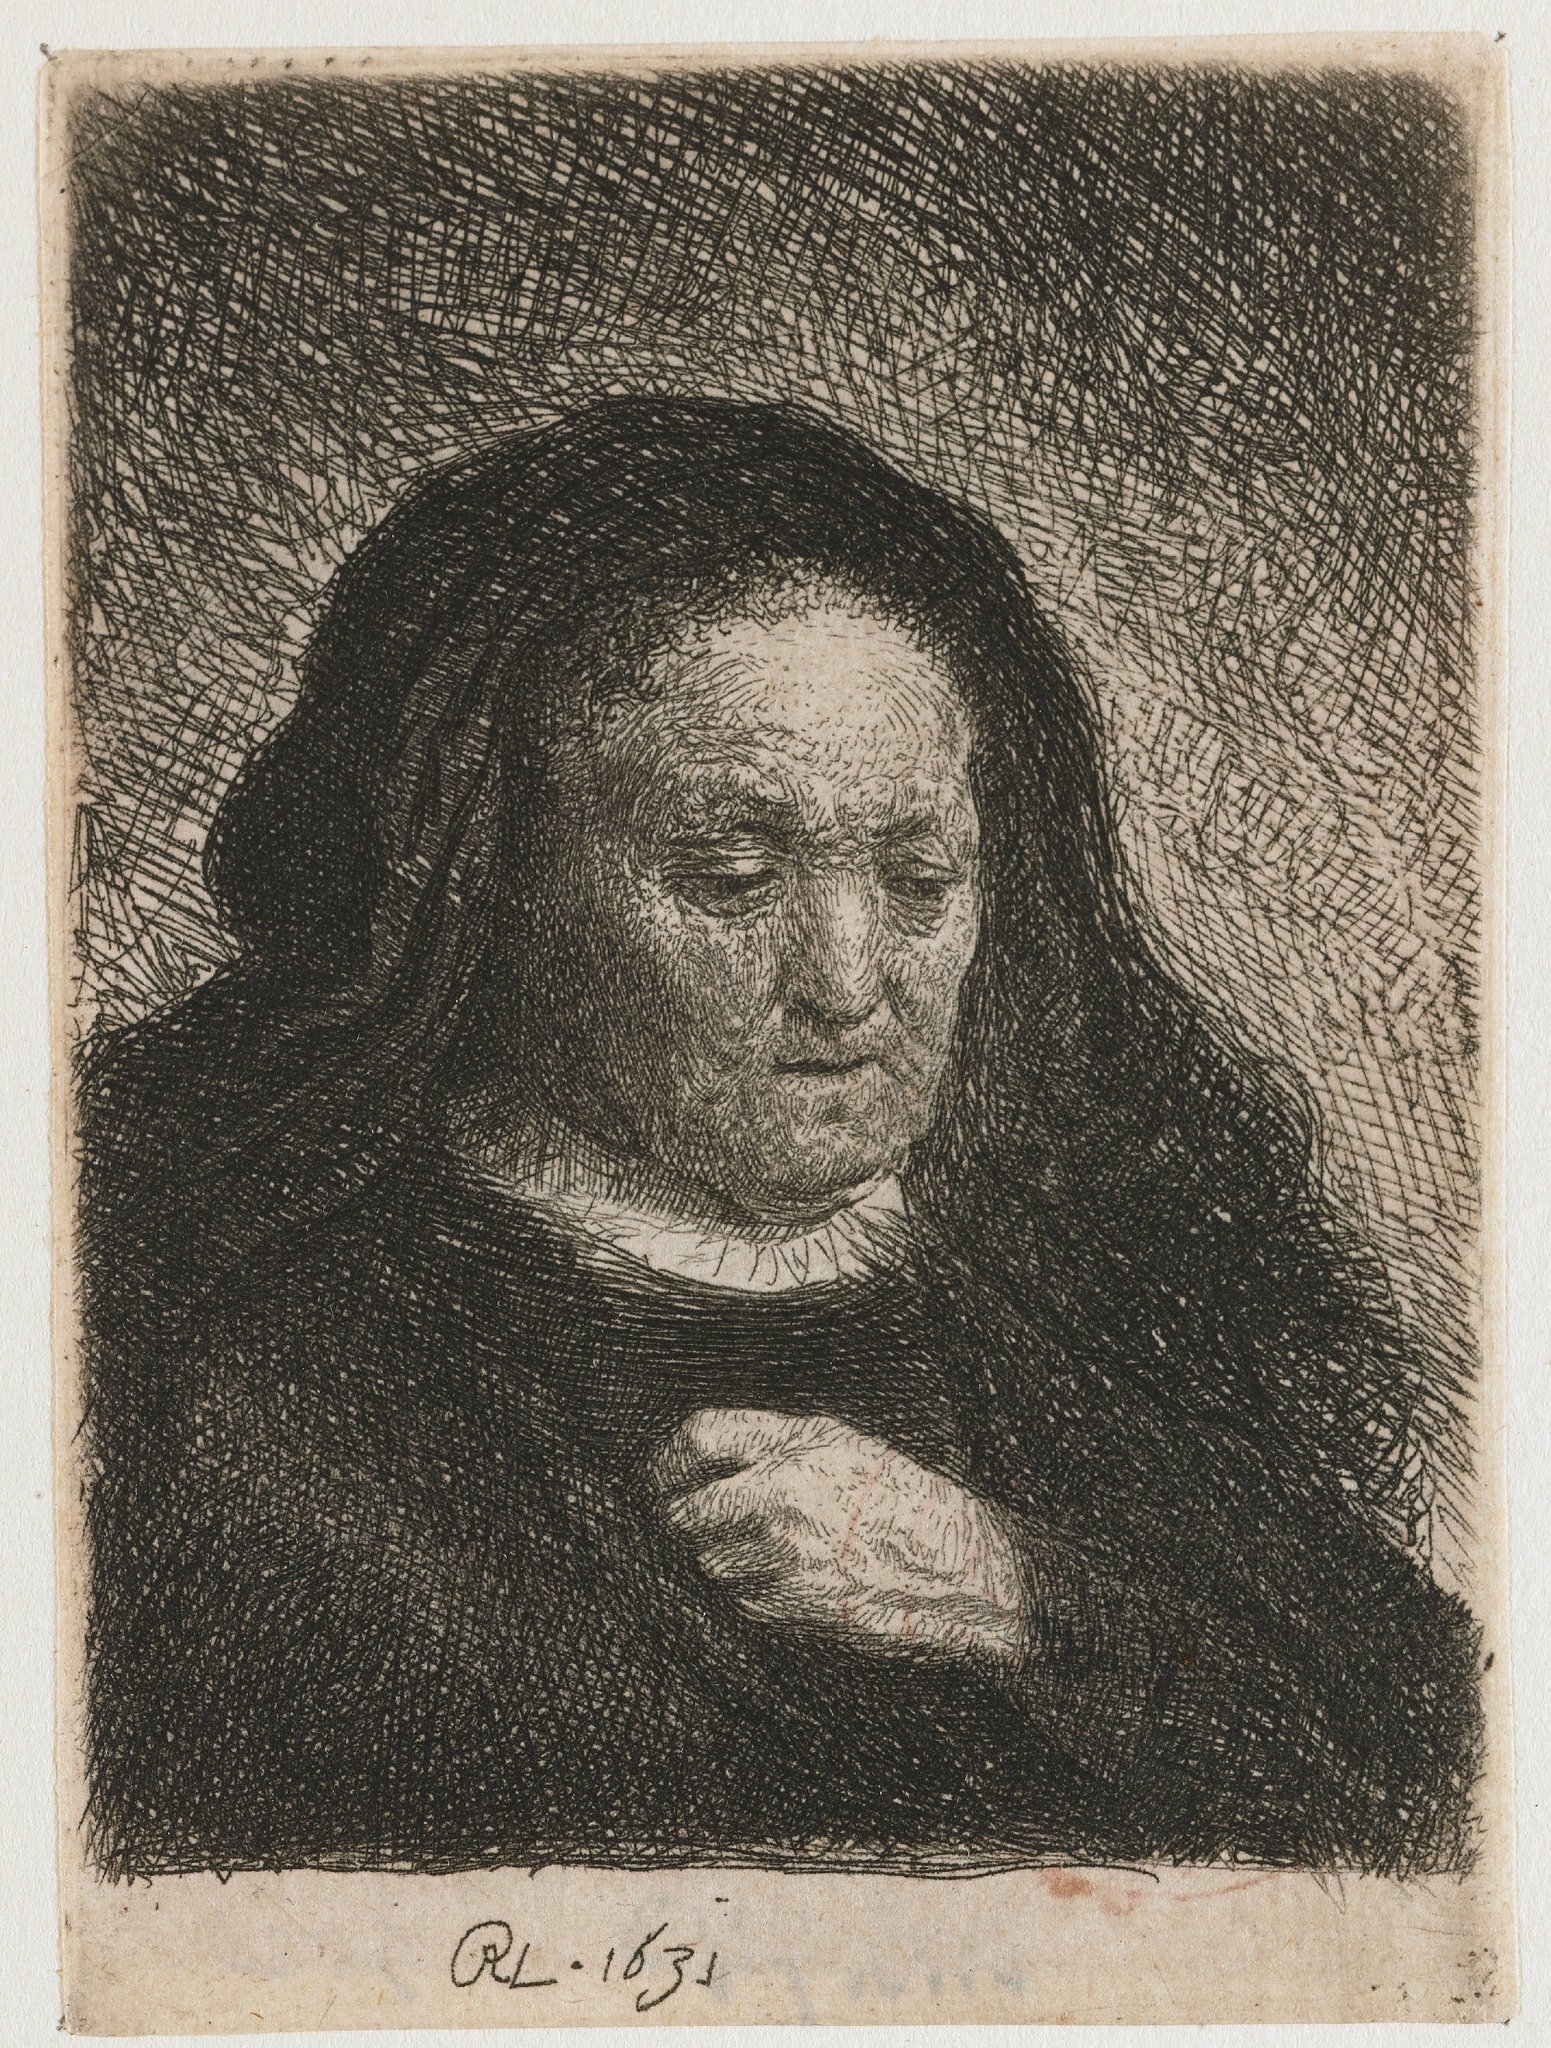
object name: print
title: The artist's mother with her hand on her chest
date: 1631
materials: paper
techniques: etching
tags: neeltje willemsdr. zuytbrouck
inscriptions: collector's mark: Lugt 240, monogram and date: ‘RHL 1631’